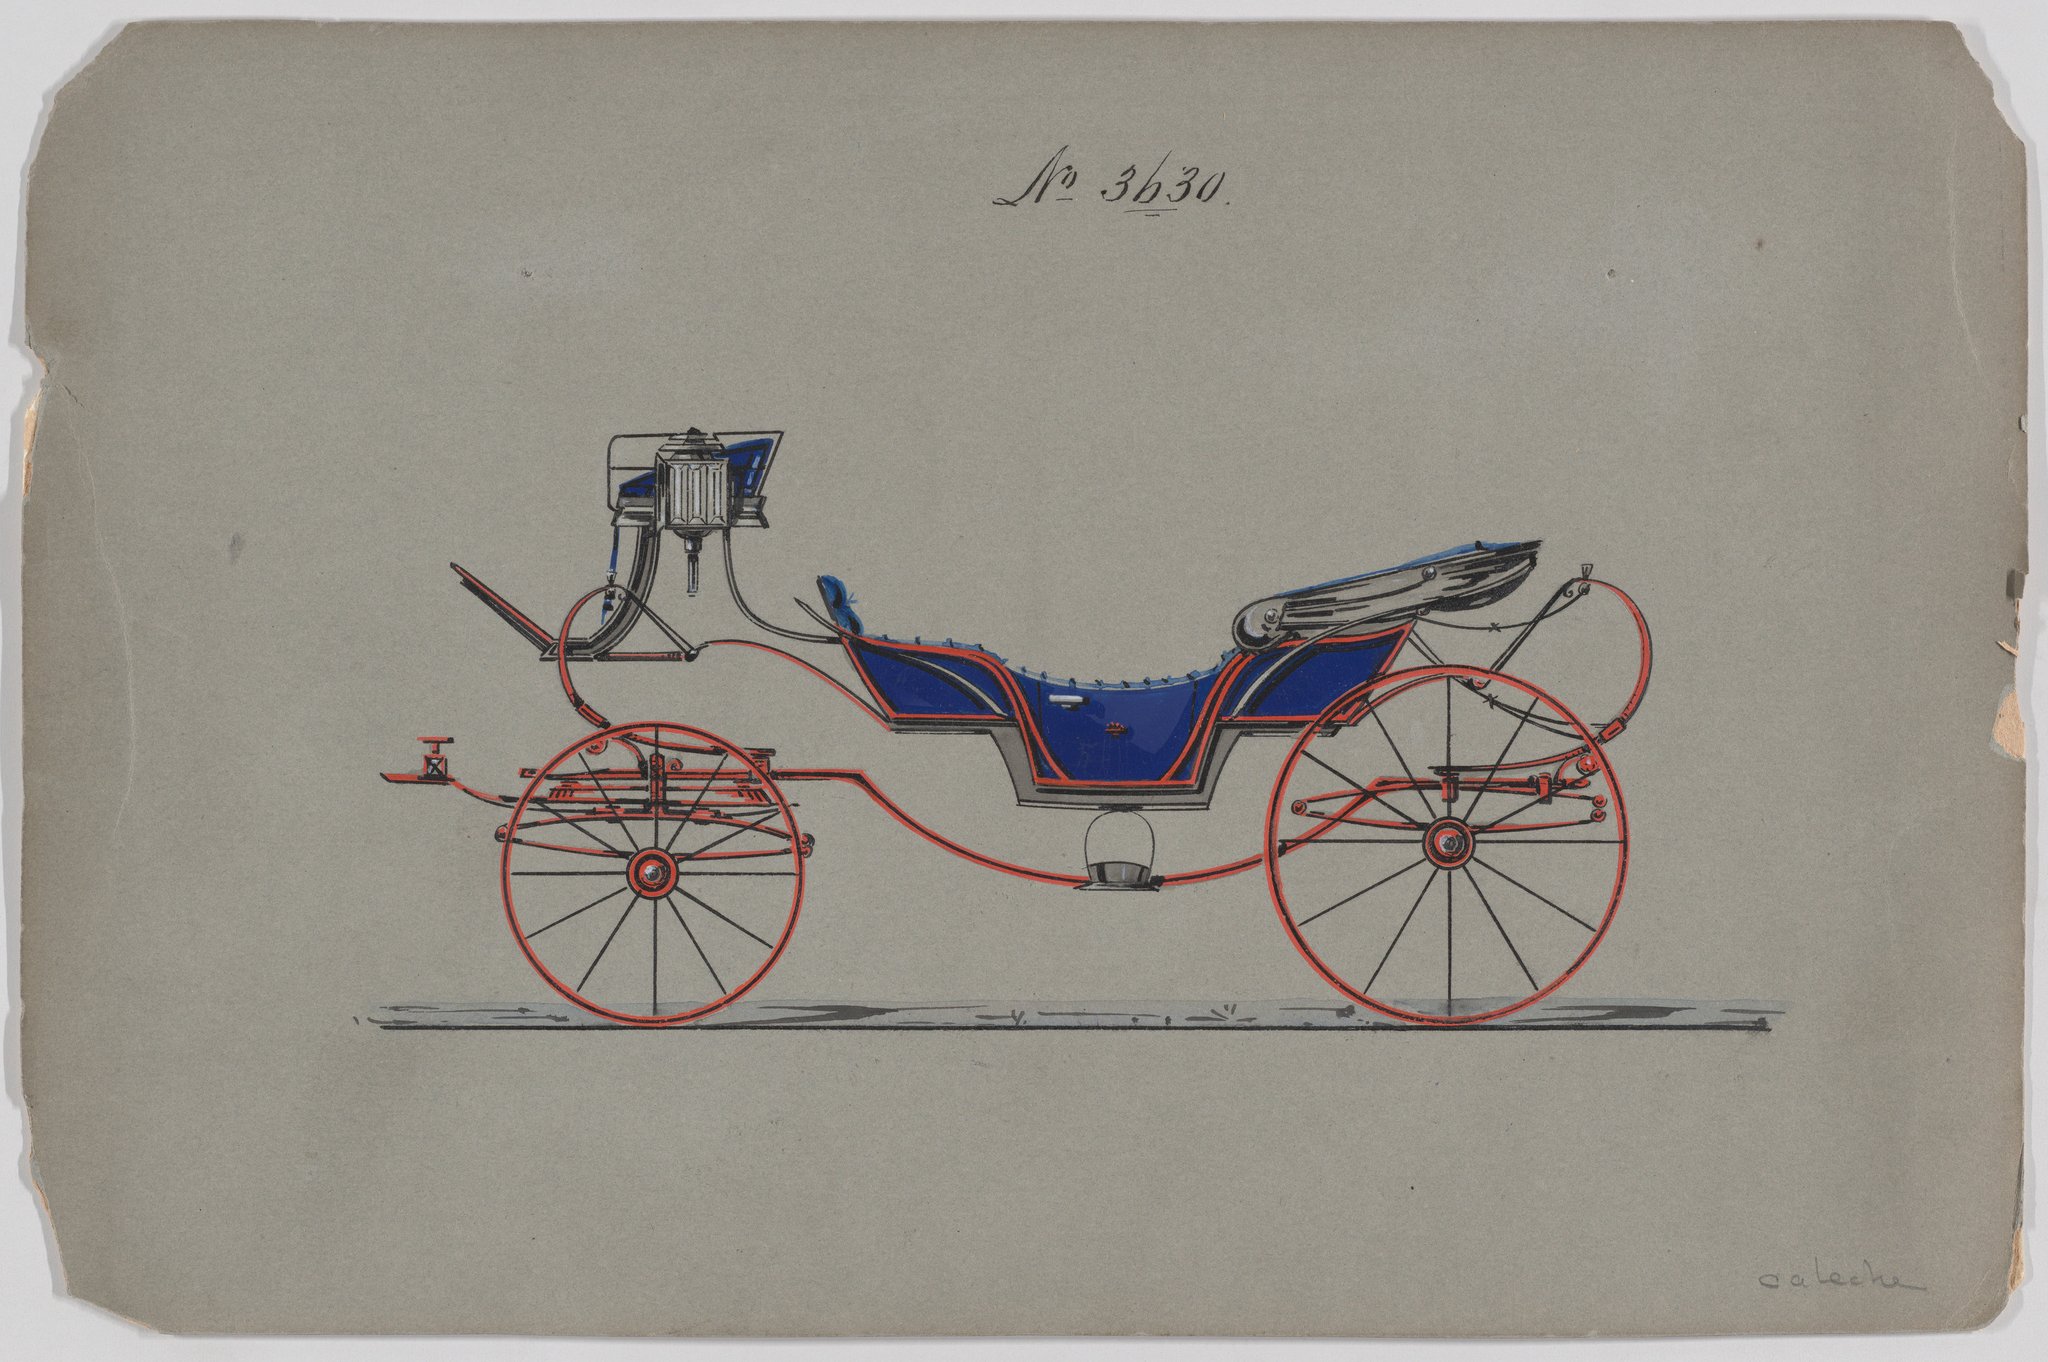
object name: drawing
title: Vis-a-vis/Caleche #3630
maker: brewster & co.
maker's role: manufacturer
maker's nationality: american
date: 1880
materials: gouache, gum arabic, ink, watercolor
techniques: pen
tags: carriages